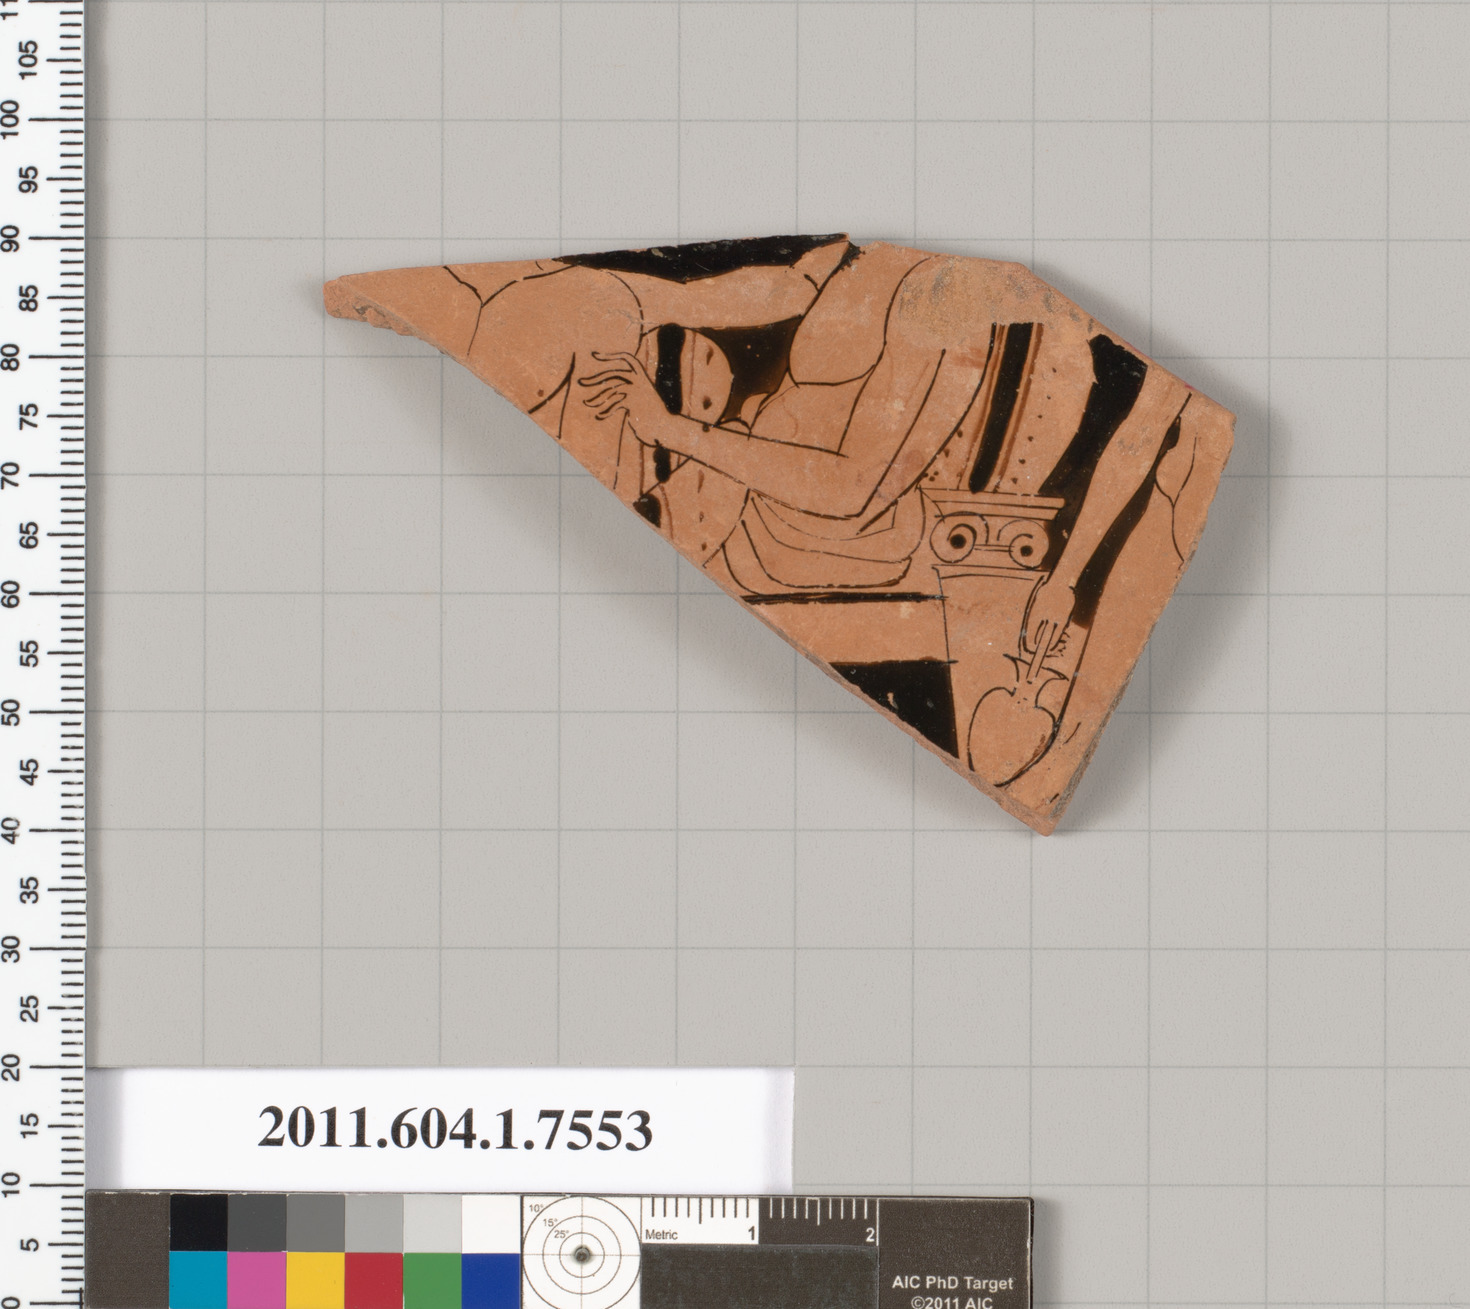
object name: kylix fragment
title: Terracotta fragment of a kylix (drinking cup)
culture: greek, attic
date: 460-450 BCE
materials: terracotta